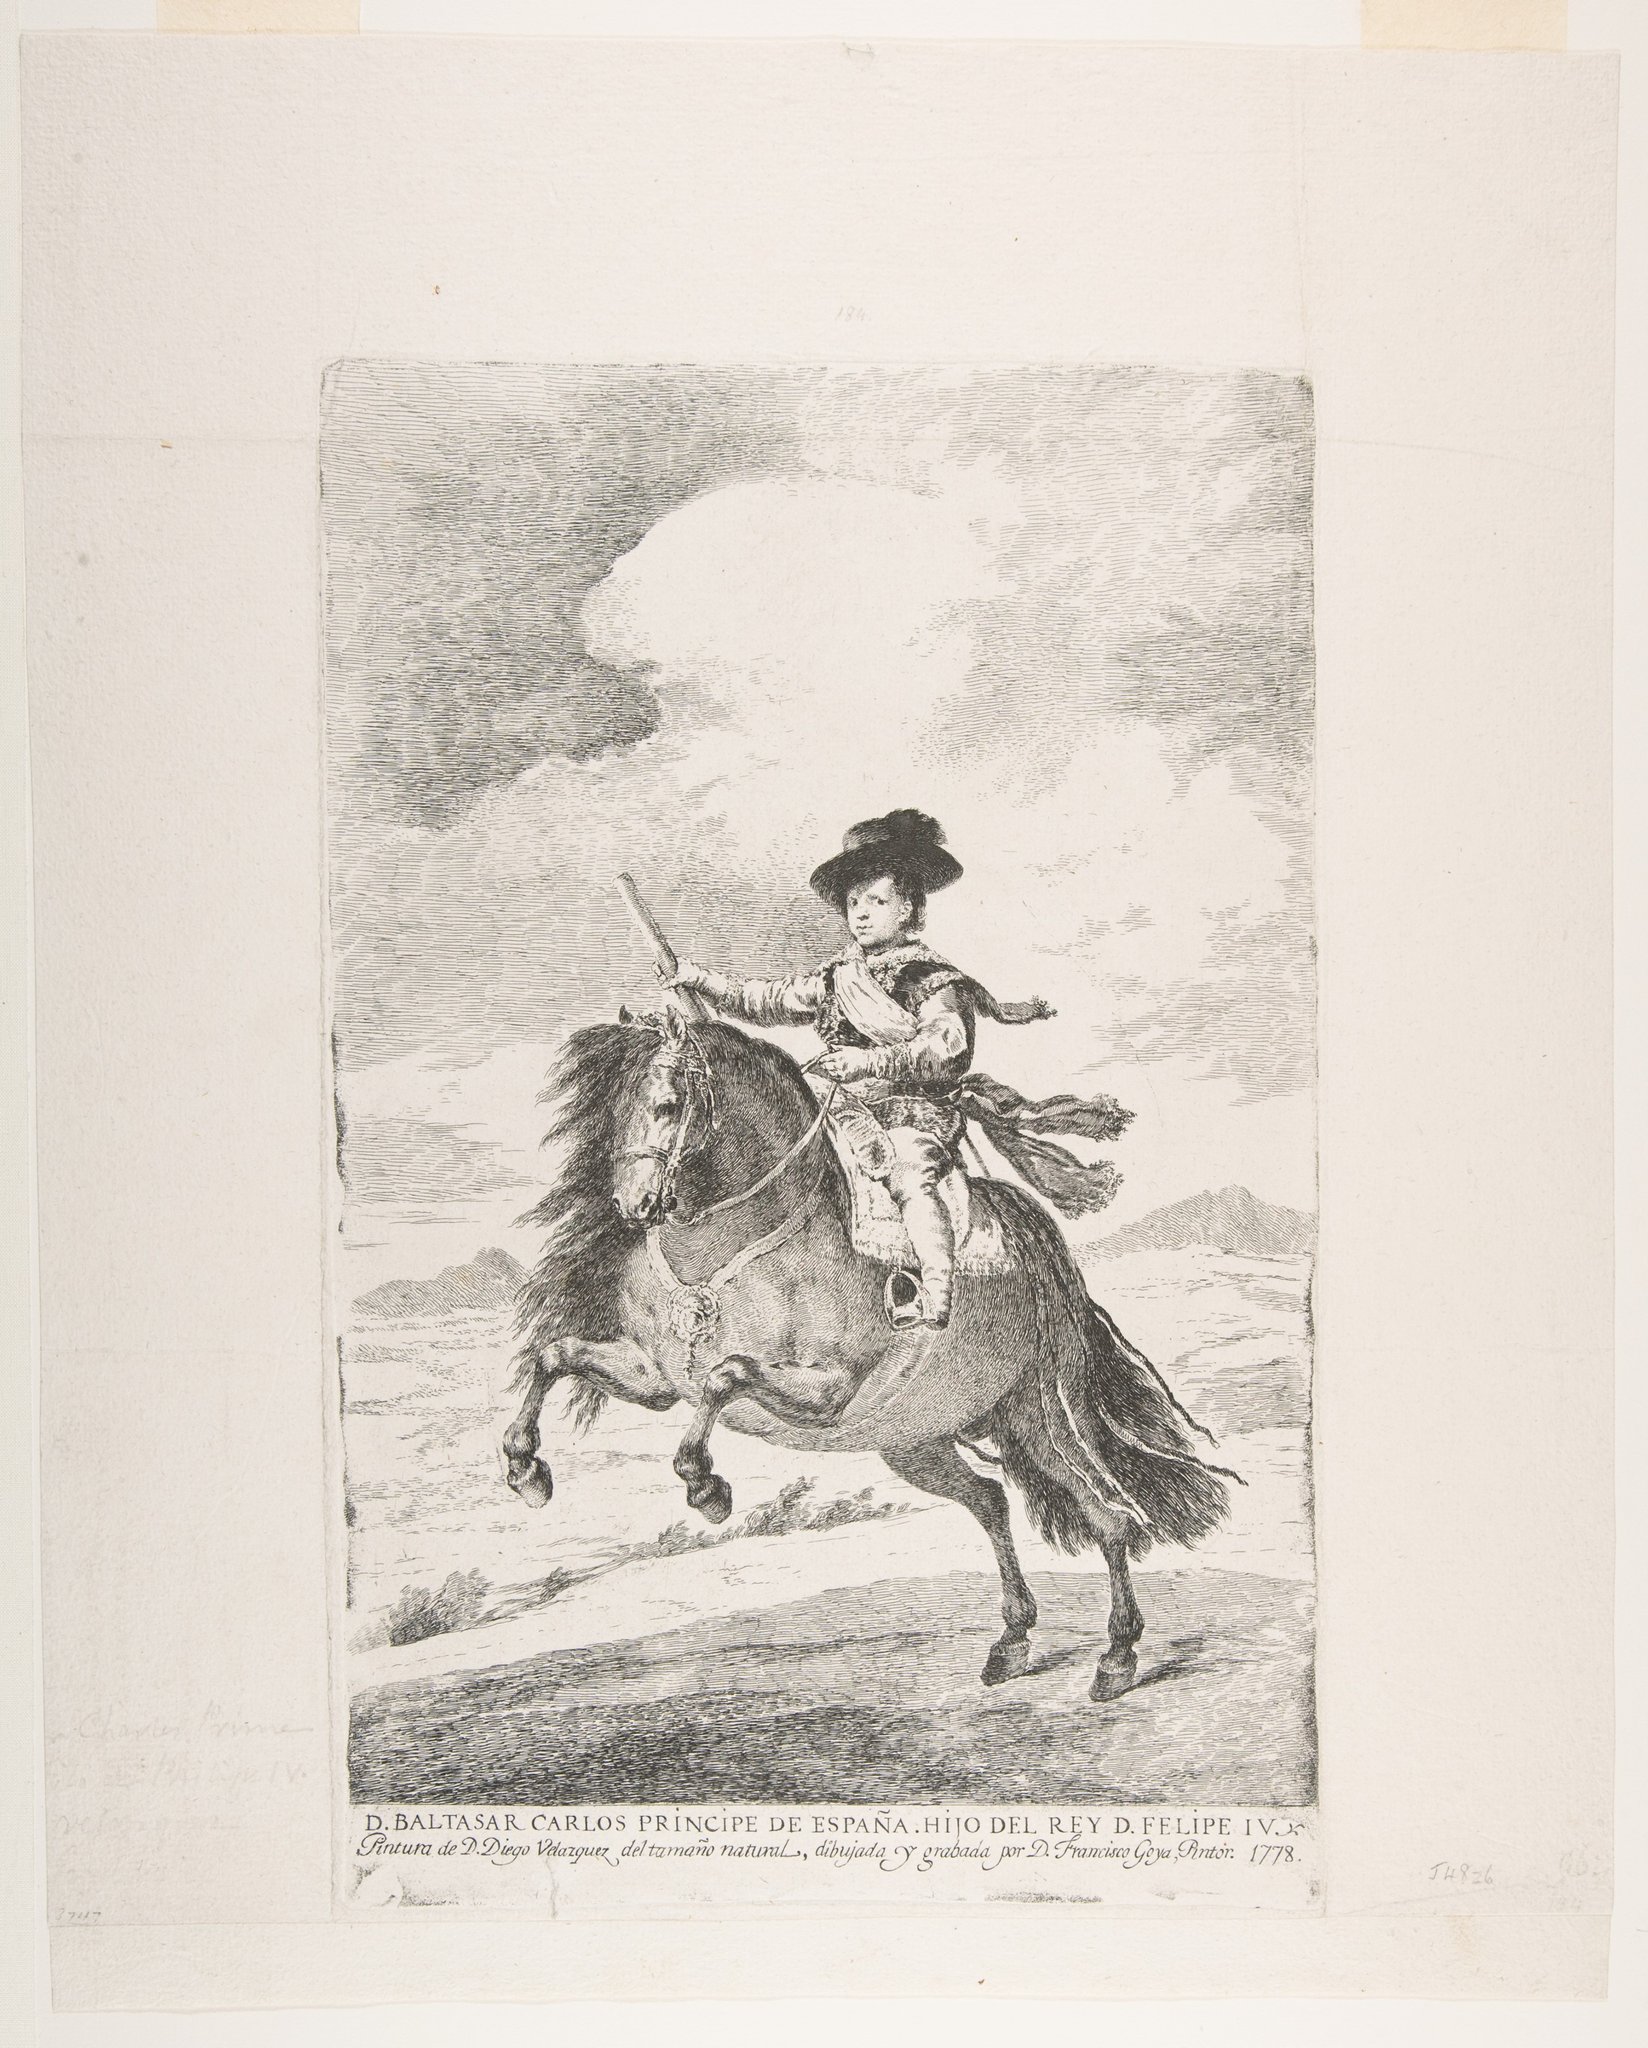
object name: print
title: Don Baltasar Carlos on horseback, after Velázquez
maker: goya (francisco de goya y lucientes)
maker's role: artist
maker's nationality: spanish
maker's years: 1746-1828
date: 1778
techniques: drypoint, etching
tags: boys,horses